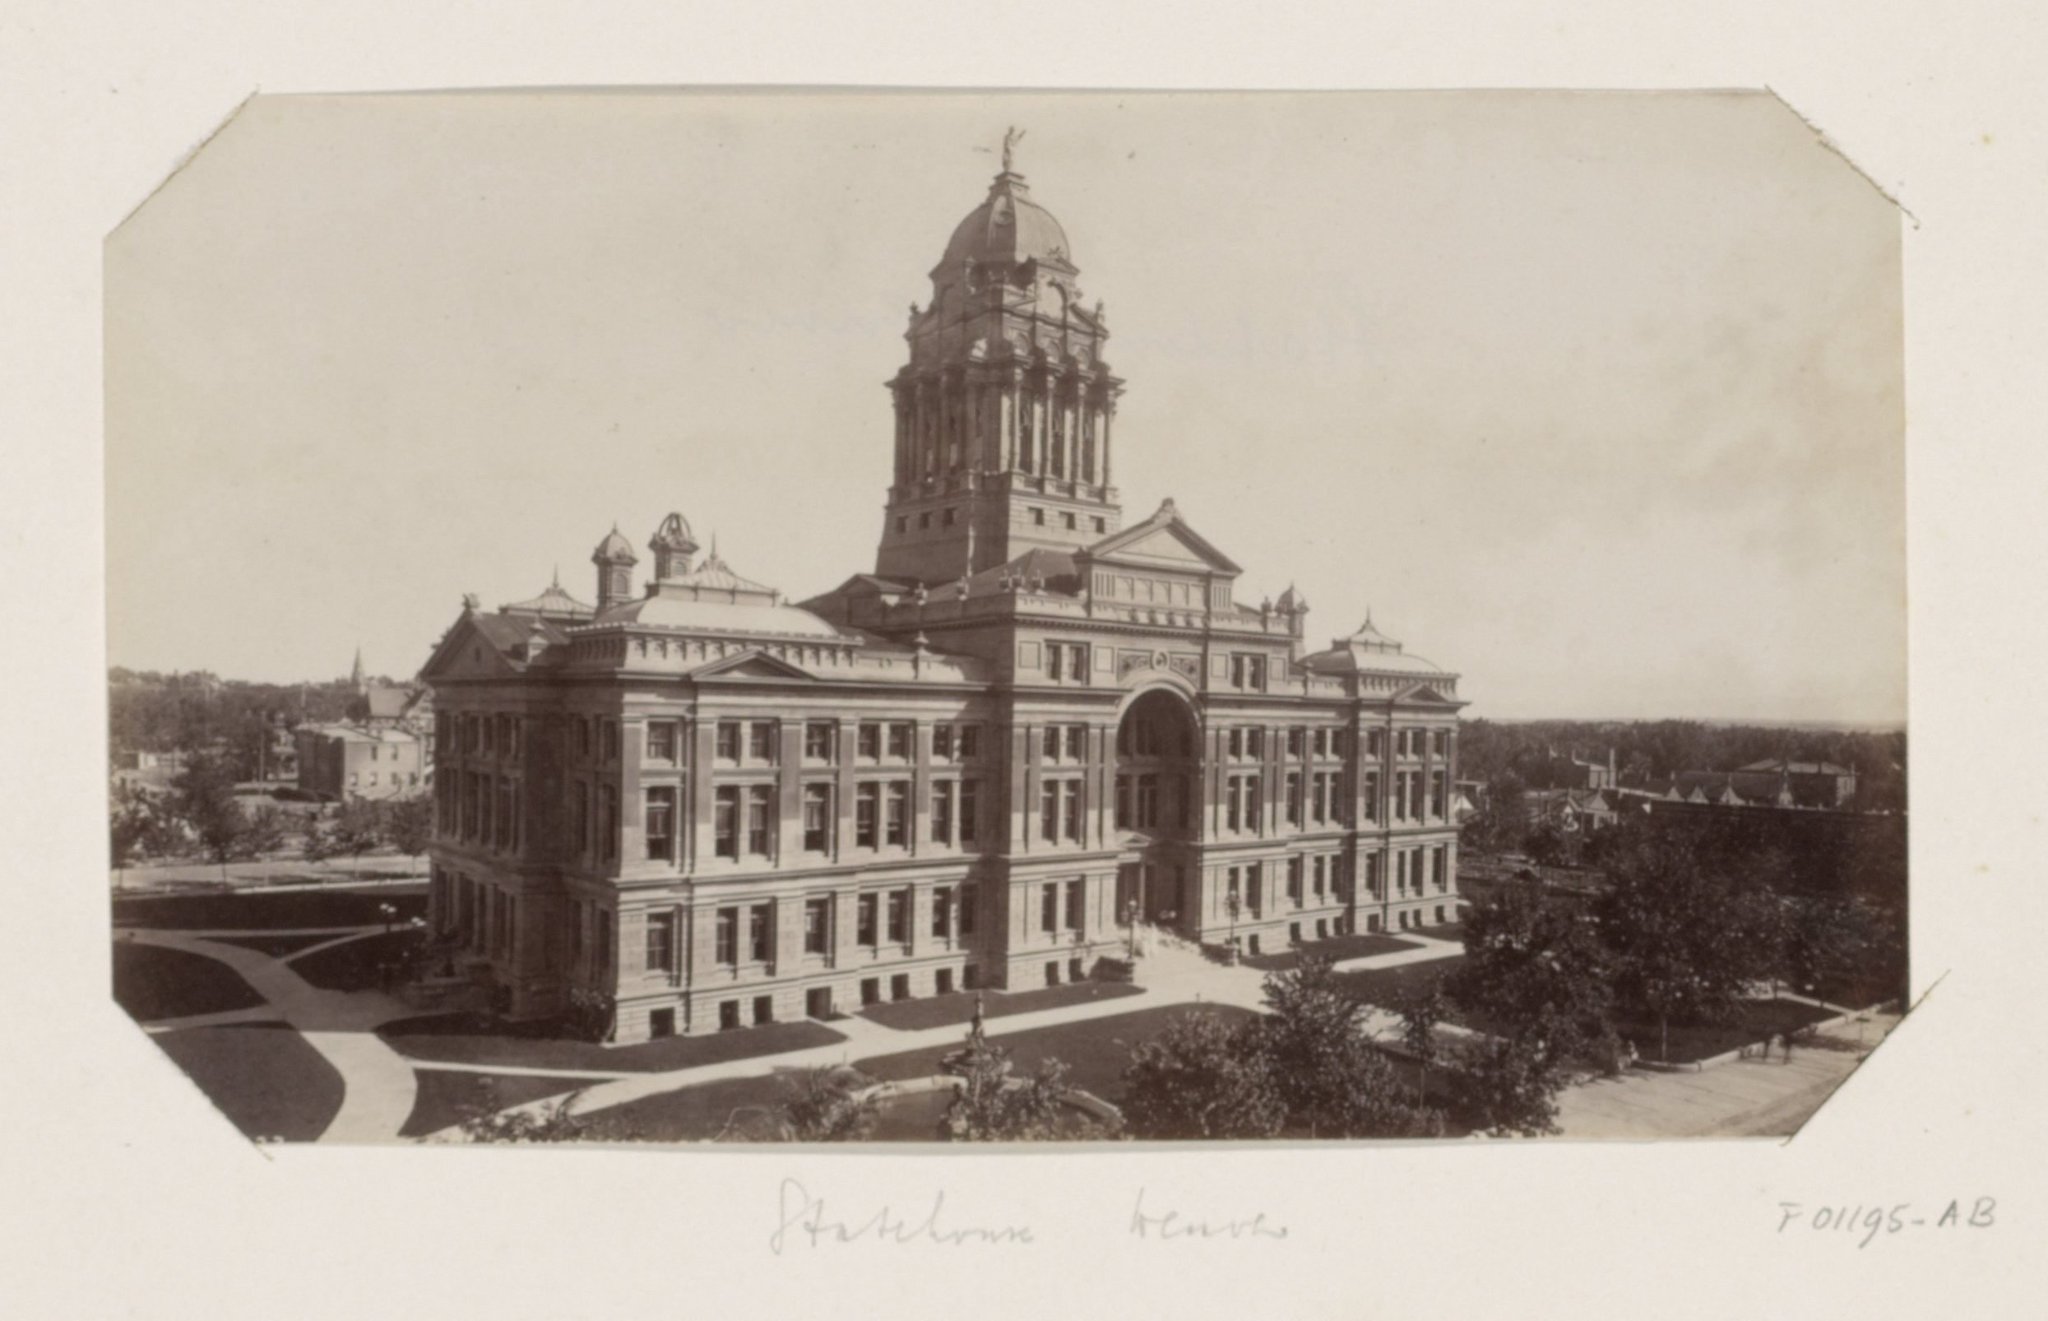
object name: photograph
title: Parlementsgebouw in Denver (vermoedelijk)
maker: william henry jackson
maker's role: fotograaf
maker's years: 1843-1942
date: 1860-1900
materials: cardboard, paper, photographic support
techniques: albumen print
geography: denver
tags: lower house, parliament, chamber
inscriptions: negative number: ‘[...]’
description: Onderdeel van Fotoalbum van een reis door de Verenigde Staten, Honolulu, Nederlands-Indië, Aden, Zanzibar en Zuidelijk Afrika.